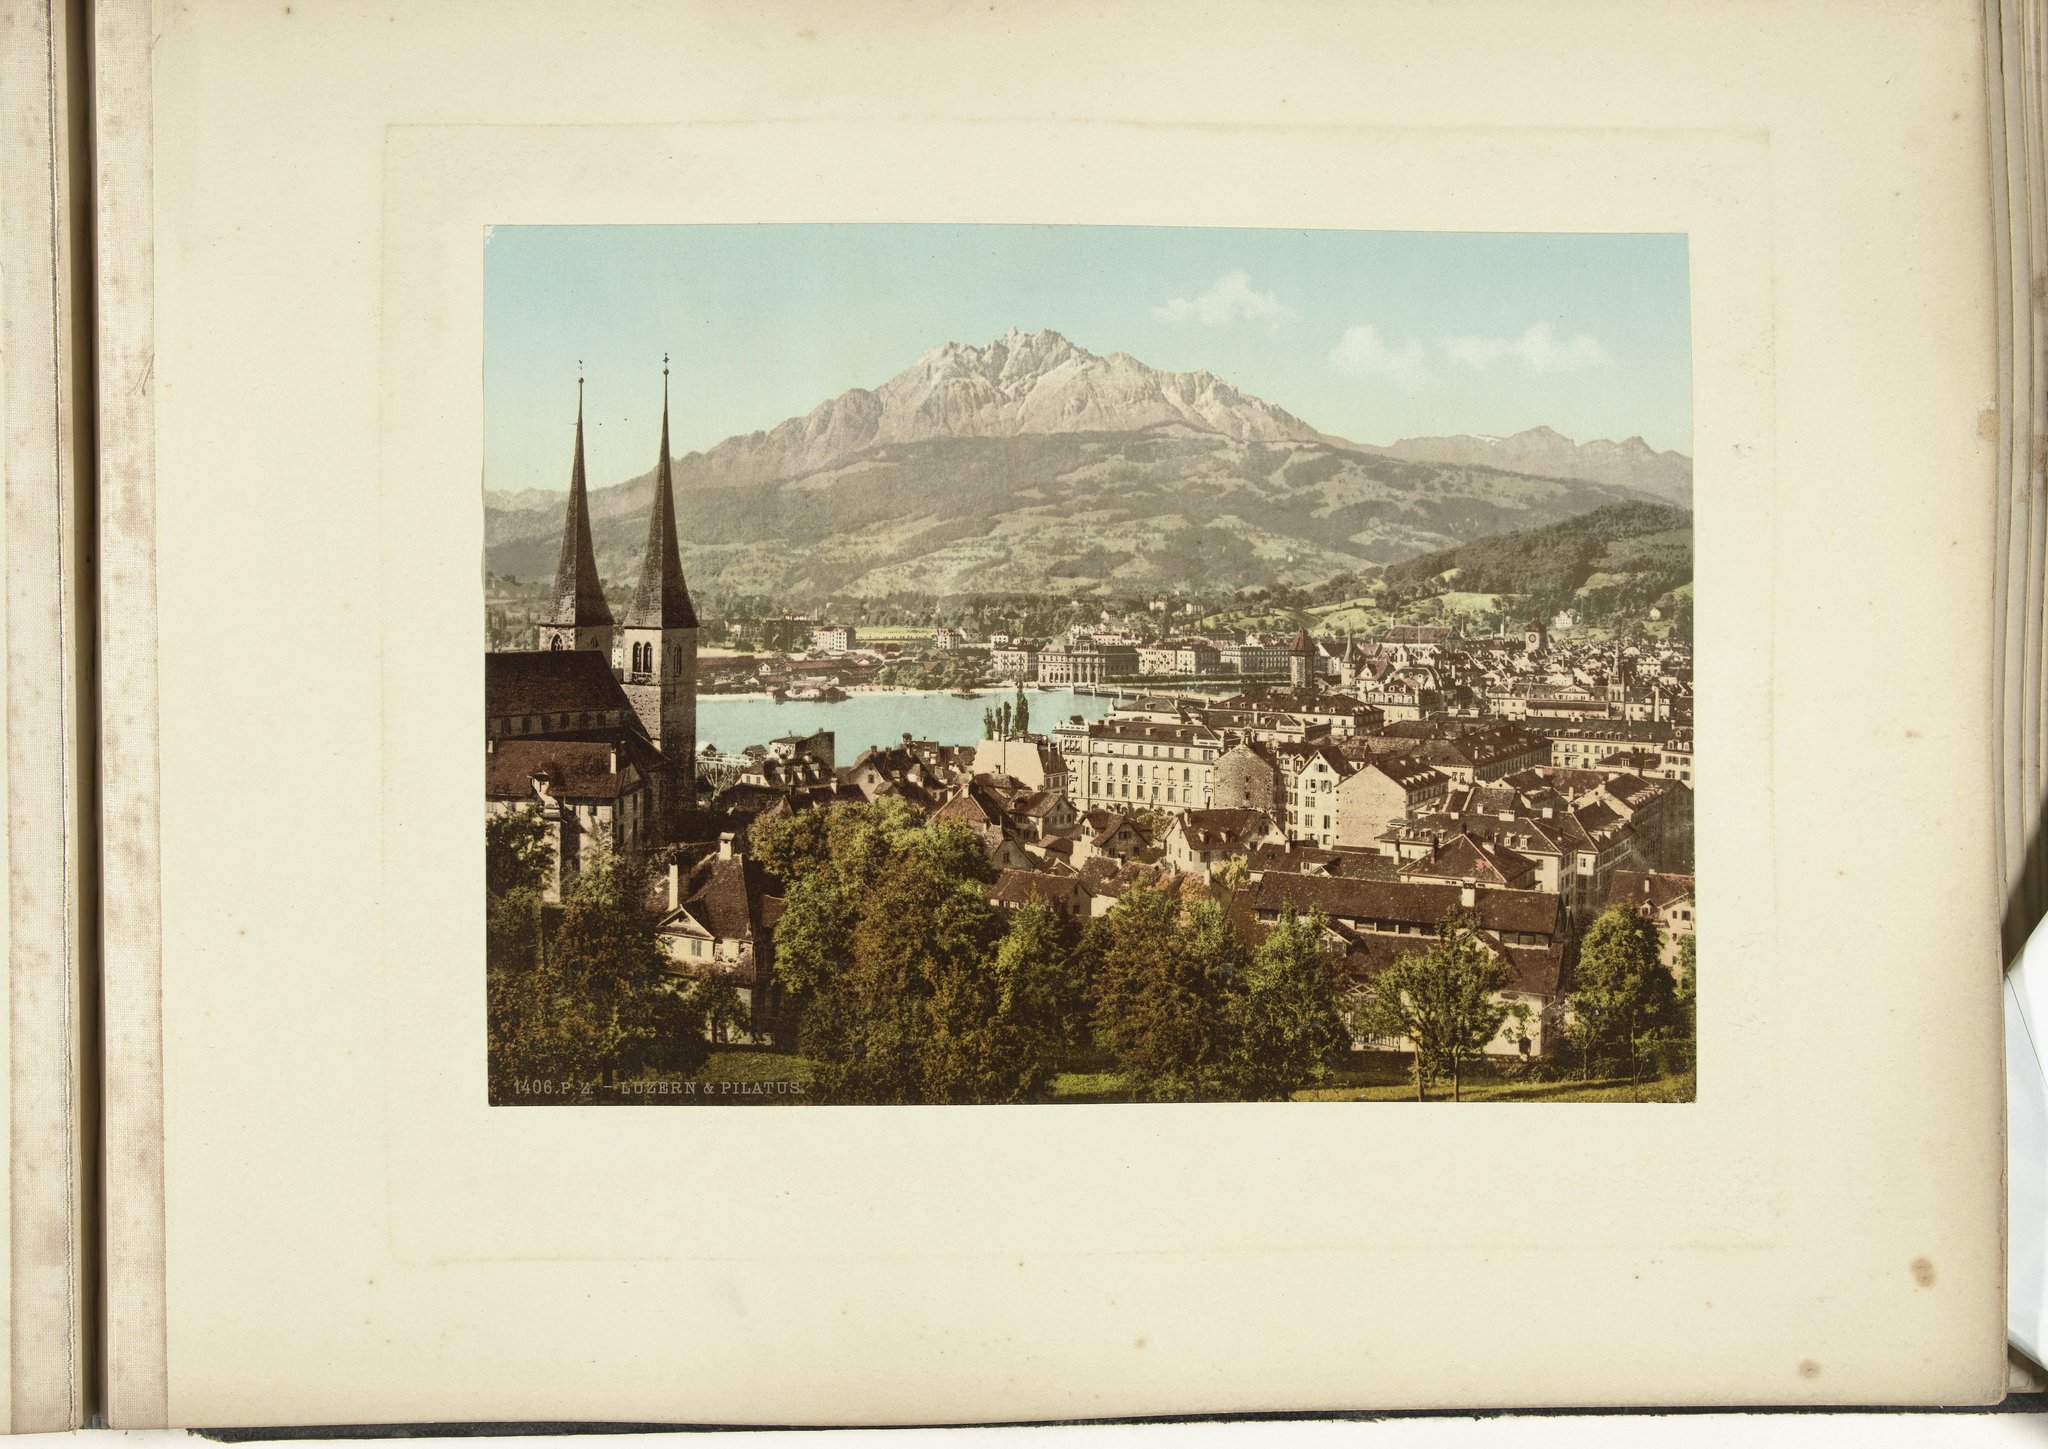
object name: album leaf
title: Stadsgezicht van Luzern gelegen tegen een berglandschap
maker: Anonymous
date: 1895-1910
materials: paper, photographic process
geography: zurich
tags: city-view in general; 'veduta', lake, parts of church exterior and annexes: tower, mountains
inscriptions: number: ‘1406.’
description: Deze prent maakt deel uit van een album.